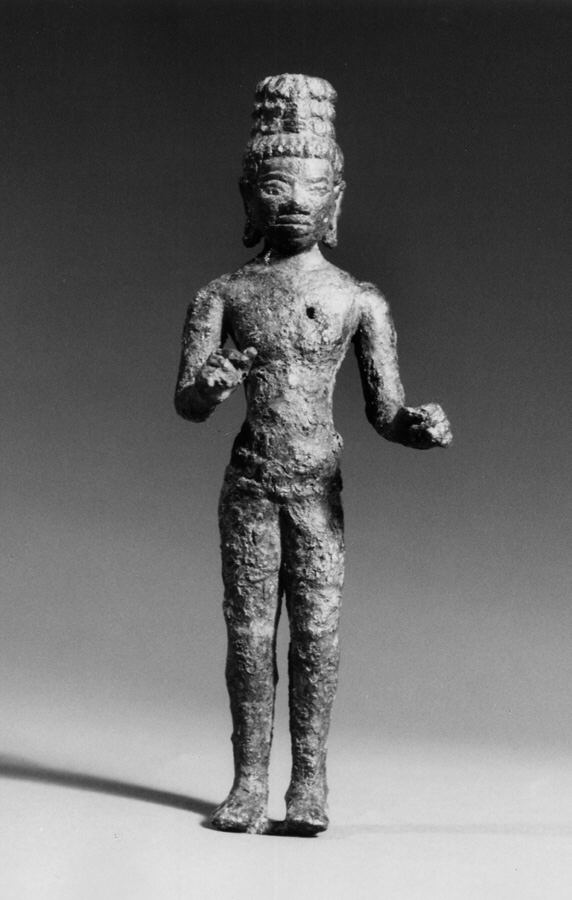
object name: figurine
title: Standing Bodhisattva, probably Avalokiteshvara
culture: plai bat ii temple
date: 701-800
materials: bronze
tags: buddhism,bodhisattvas